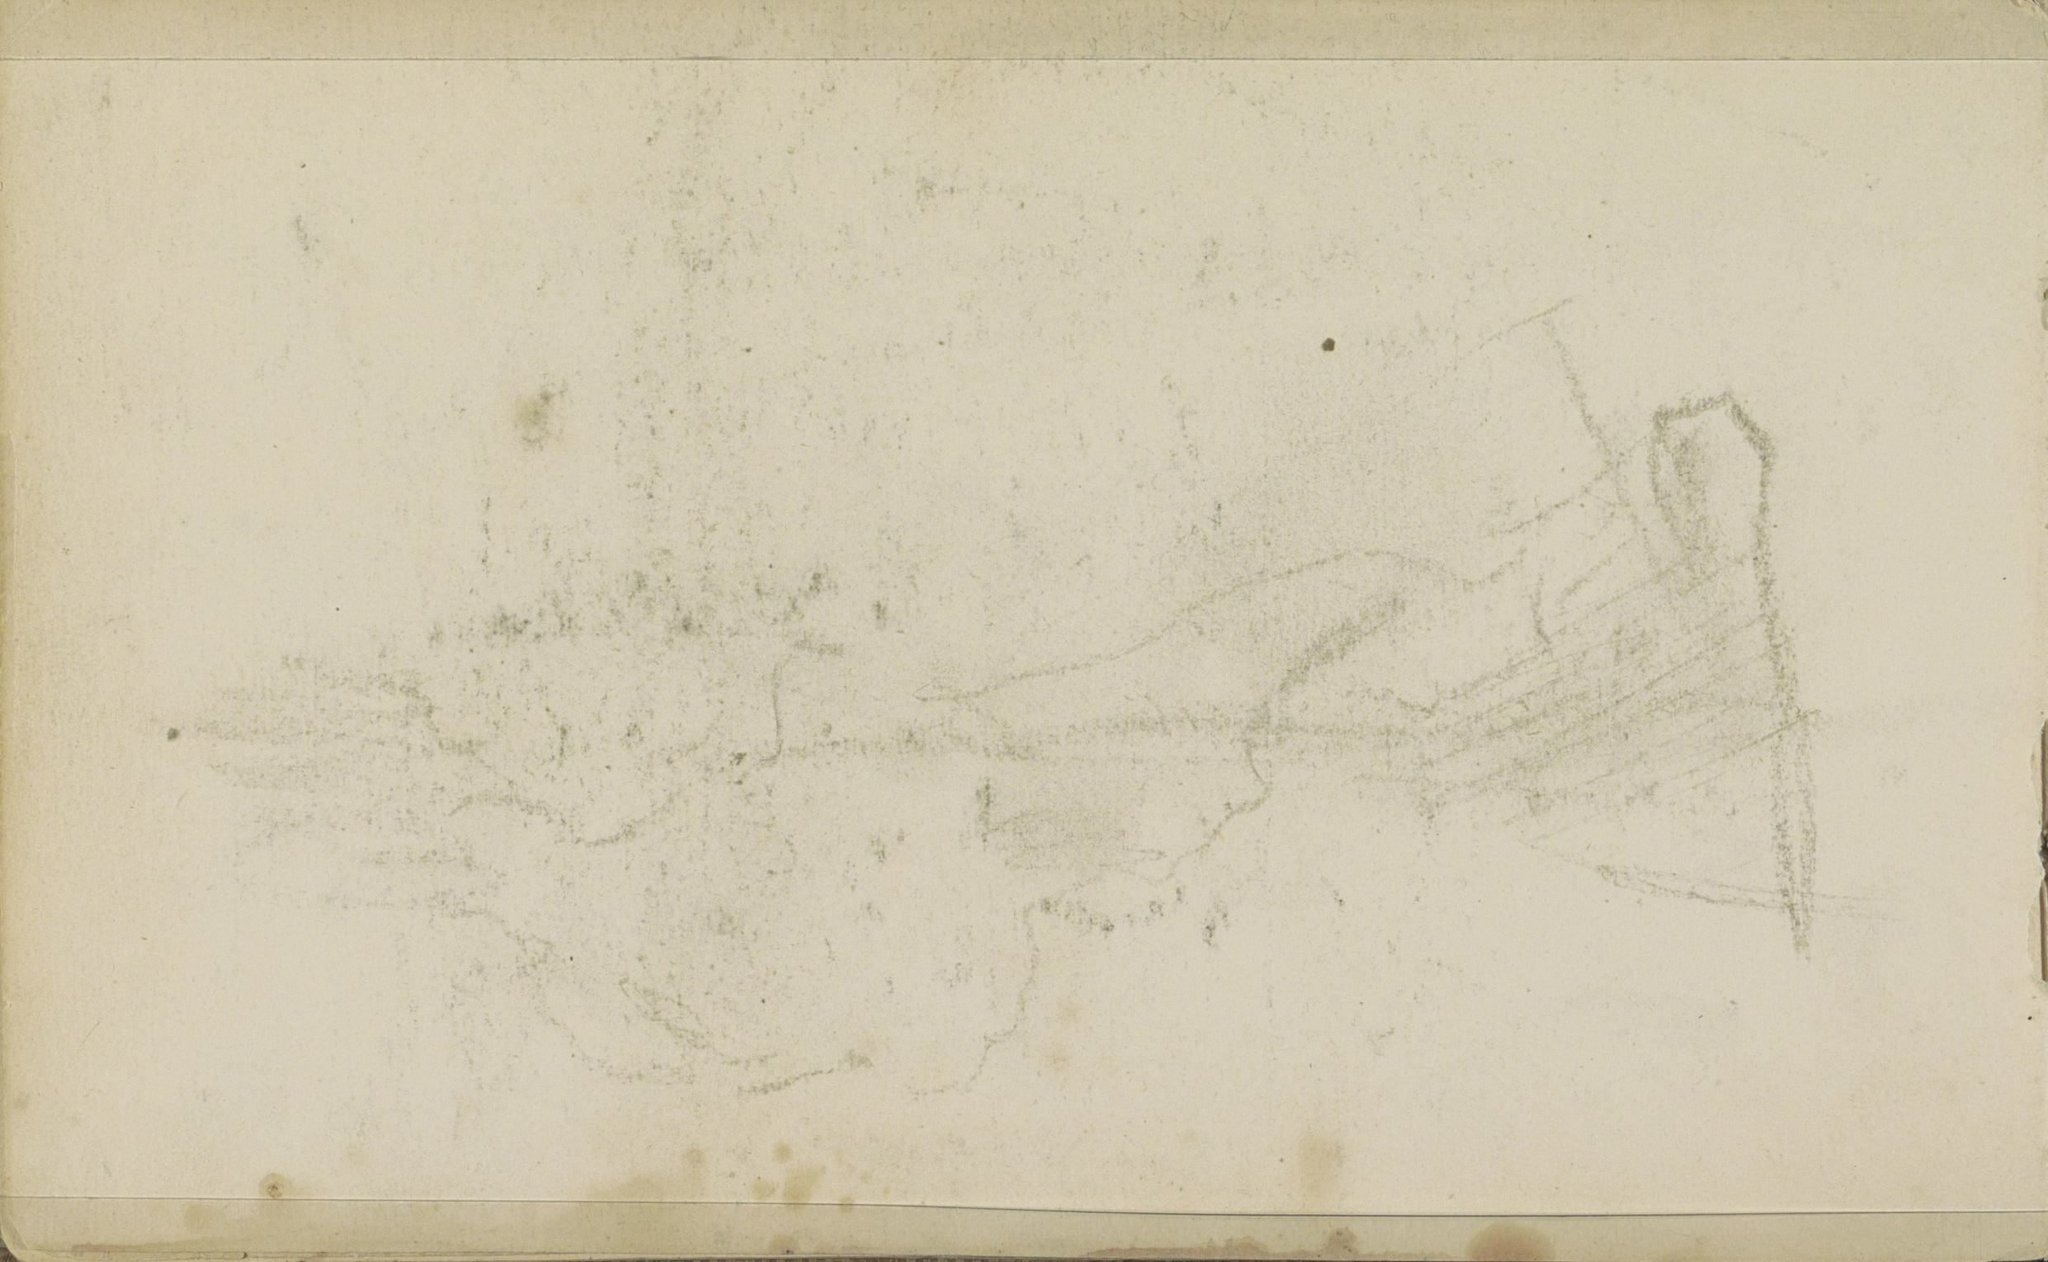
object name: sketchbook leaf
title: Studie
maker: jozef israëls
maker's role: draughtsman, painter, print maker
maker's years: 1824-1911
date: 1834-1911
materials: chalk, paper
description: Blad 16 verso uit een schetsboek met 42 bladen.